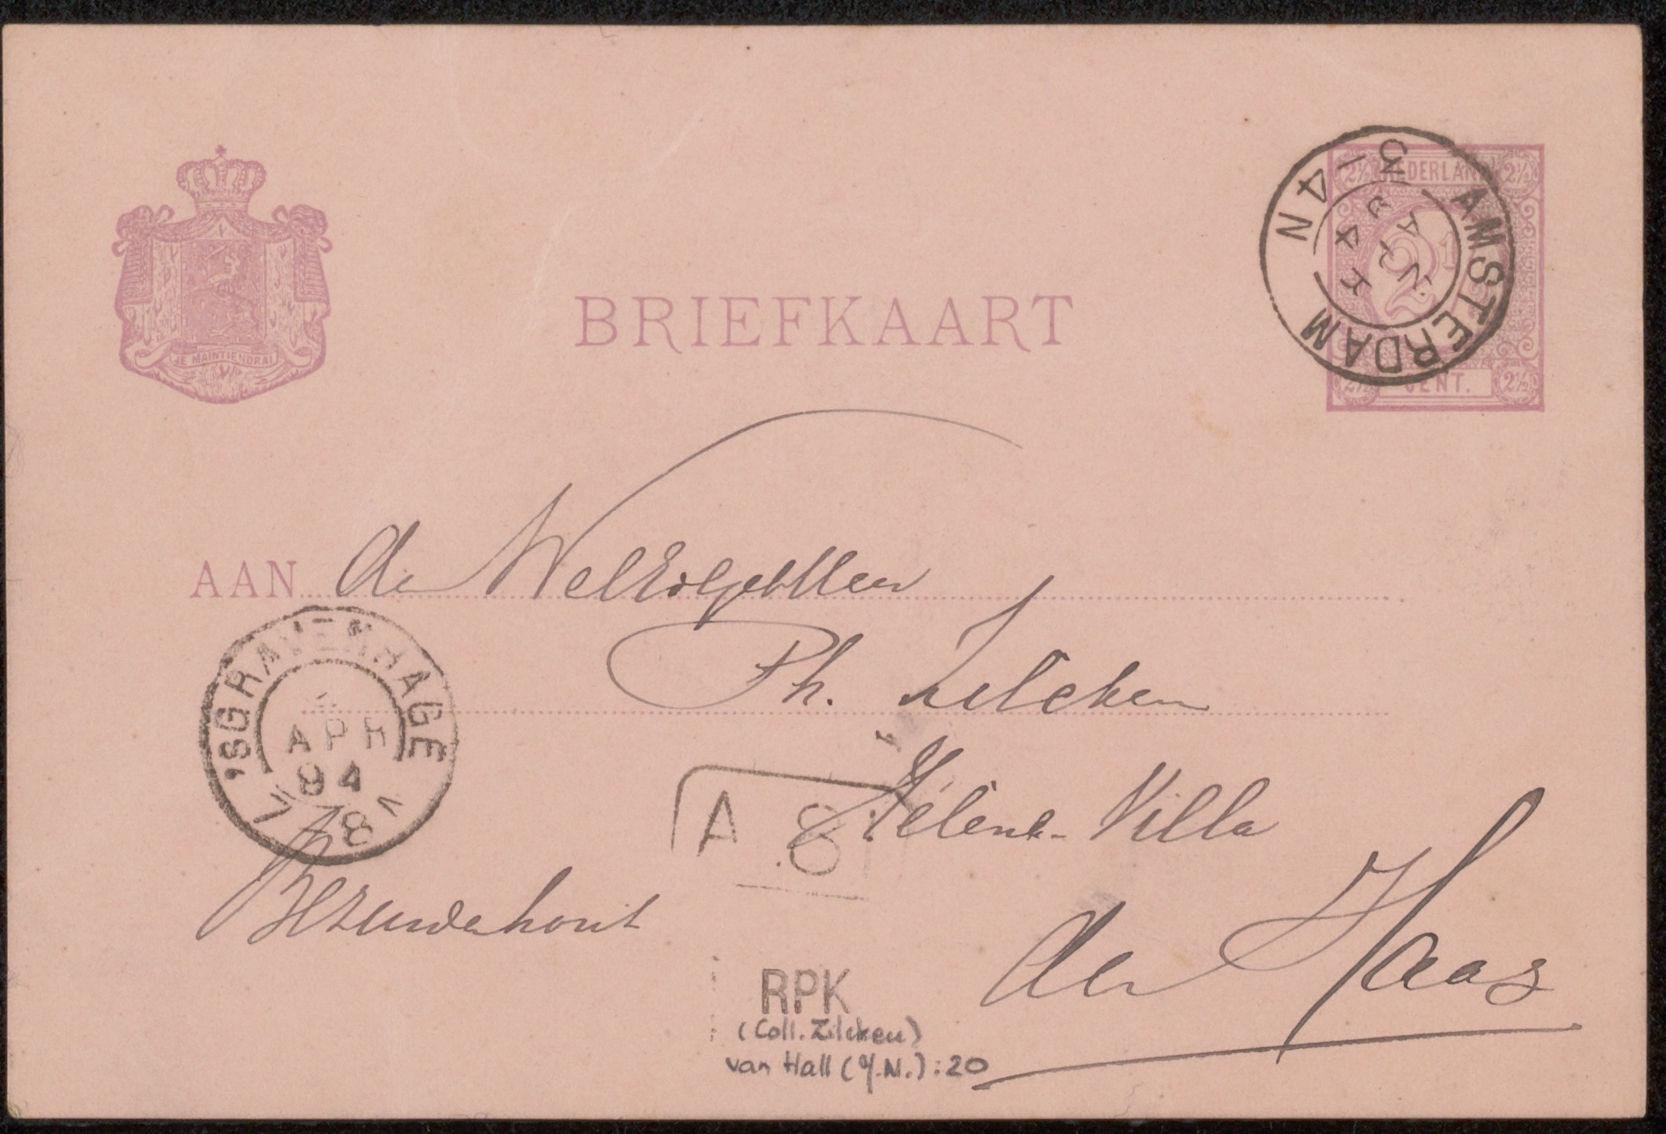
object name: postcard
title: Briefkaart aan Philip Zilcken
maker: jacob nicolaas van hall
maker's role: politician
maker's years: 1840-1918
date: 1894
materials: cardboard, ink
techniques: pen, writing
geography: amsterdam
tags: amsterdam, print maker, draughtsman, marius bauer, painter, philip zilcken, the graphic arts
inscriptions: collector's mark: ‘RPK’